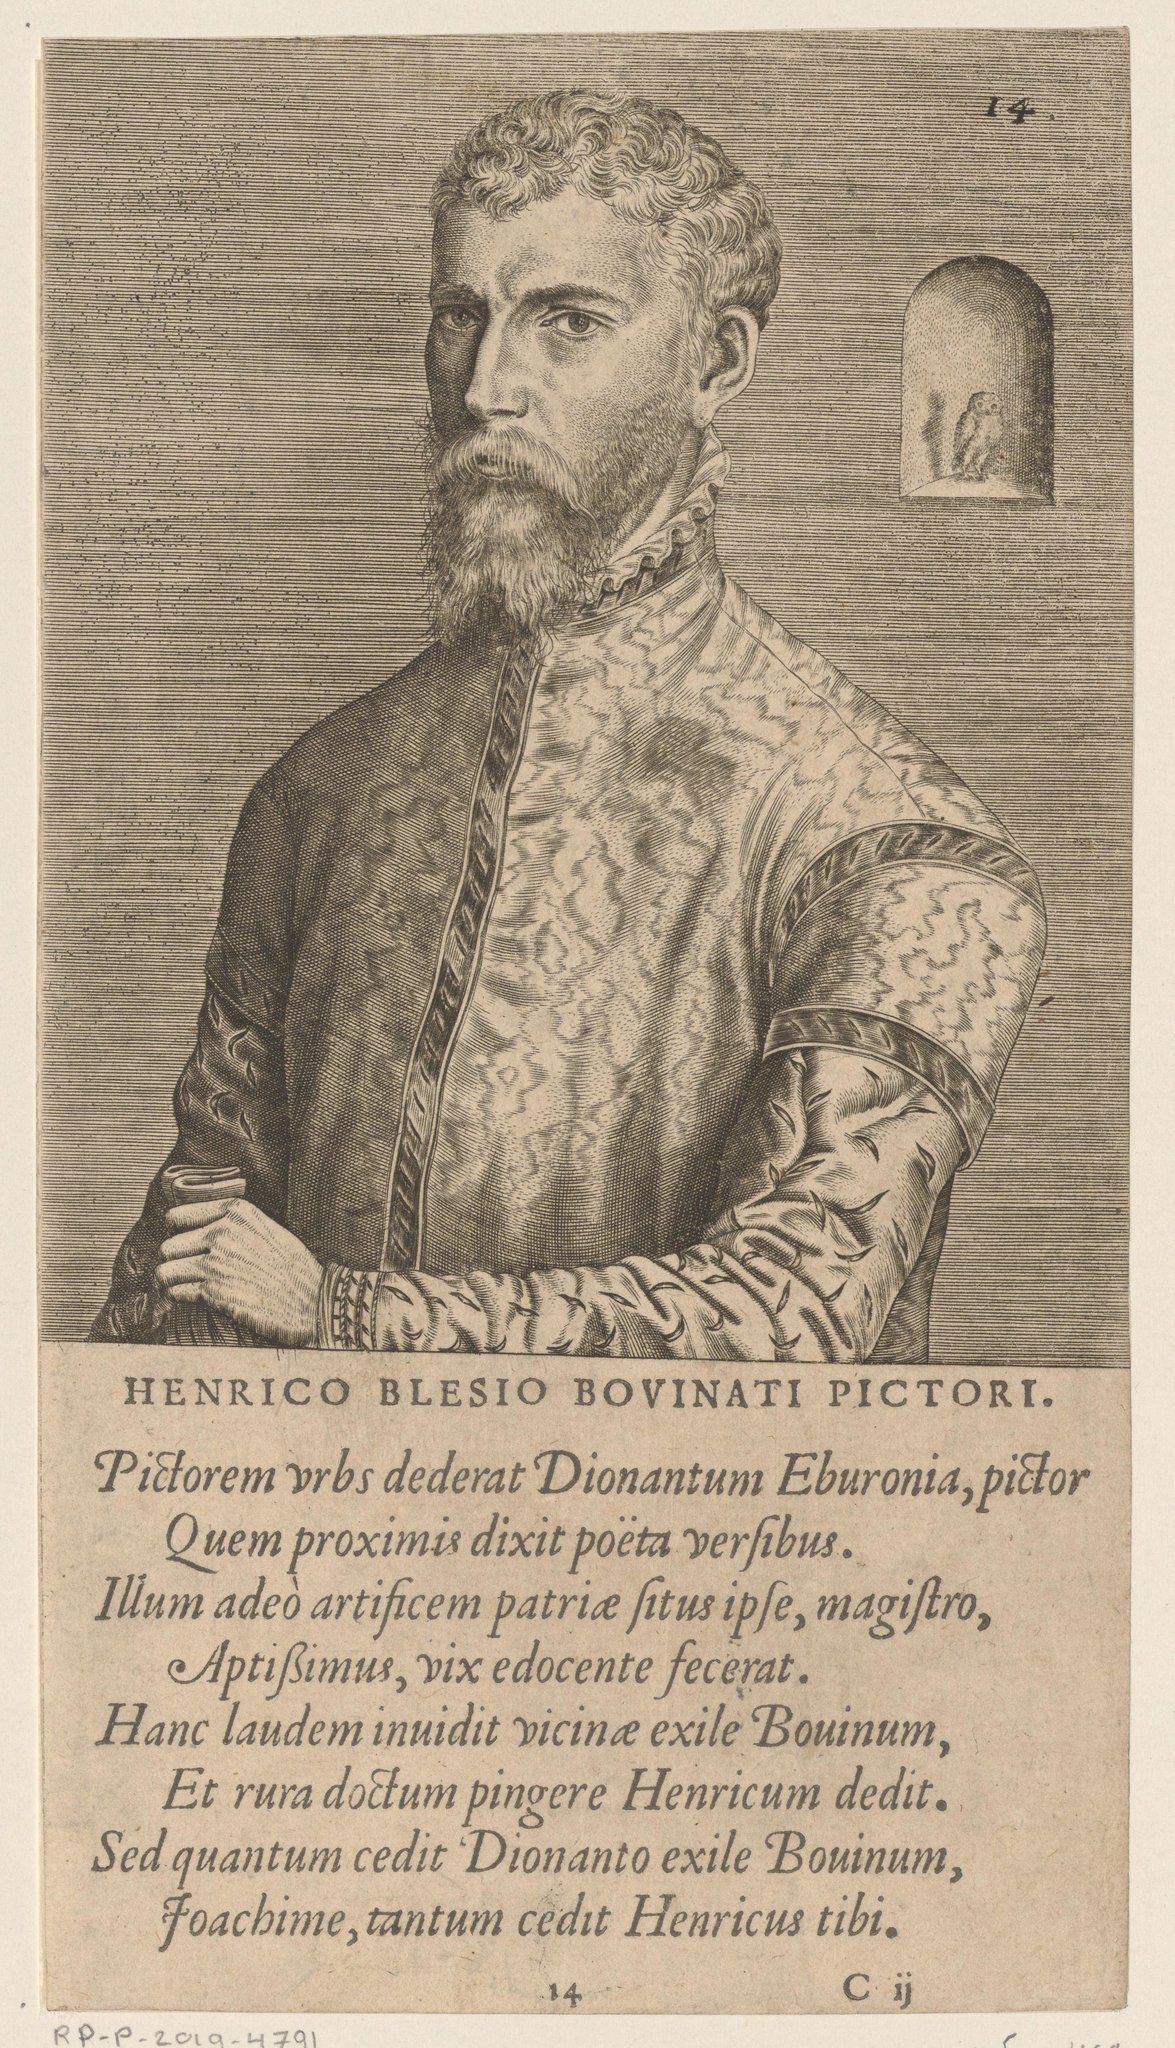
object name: print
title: Pictorum aliquot celebrium Germaniae Inferioris effigies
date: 1572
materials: paper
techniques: engraving, letterpress printing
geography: antwerp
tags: print maker, herri met de bles, historical persons, portrait, self-portrait of painter, owls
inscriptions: collector's mark: Lugt 2165